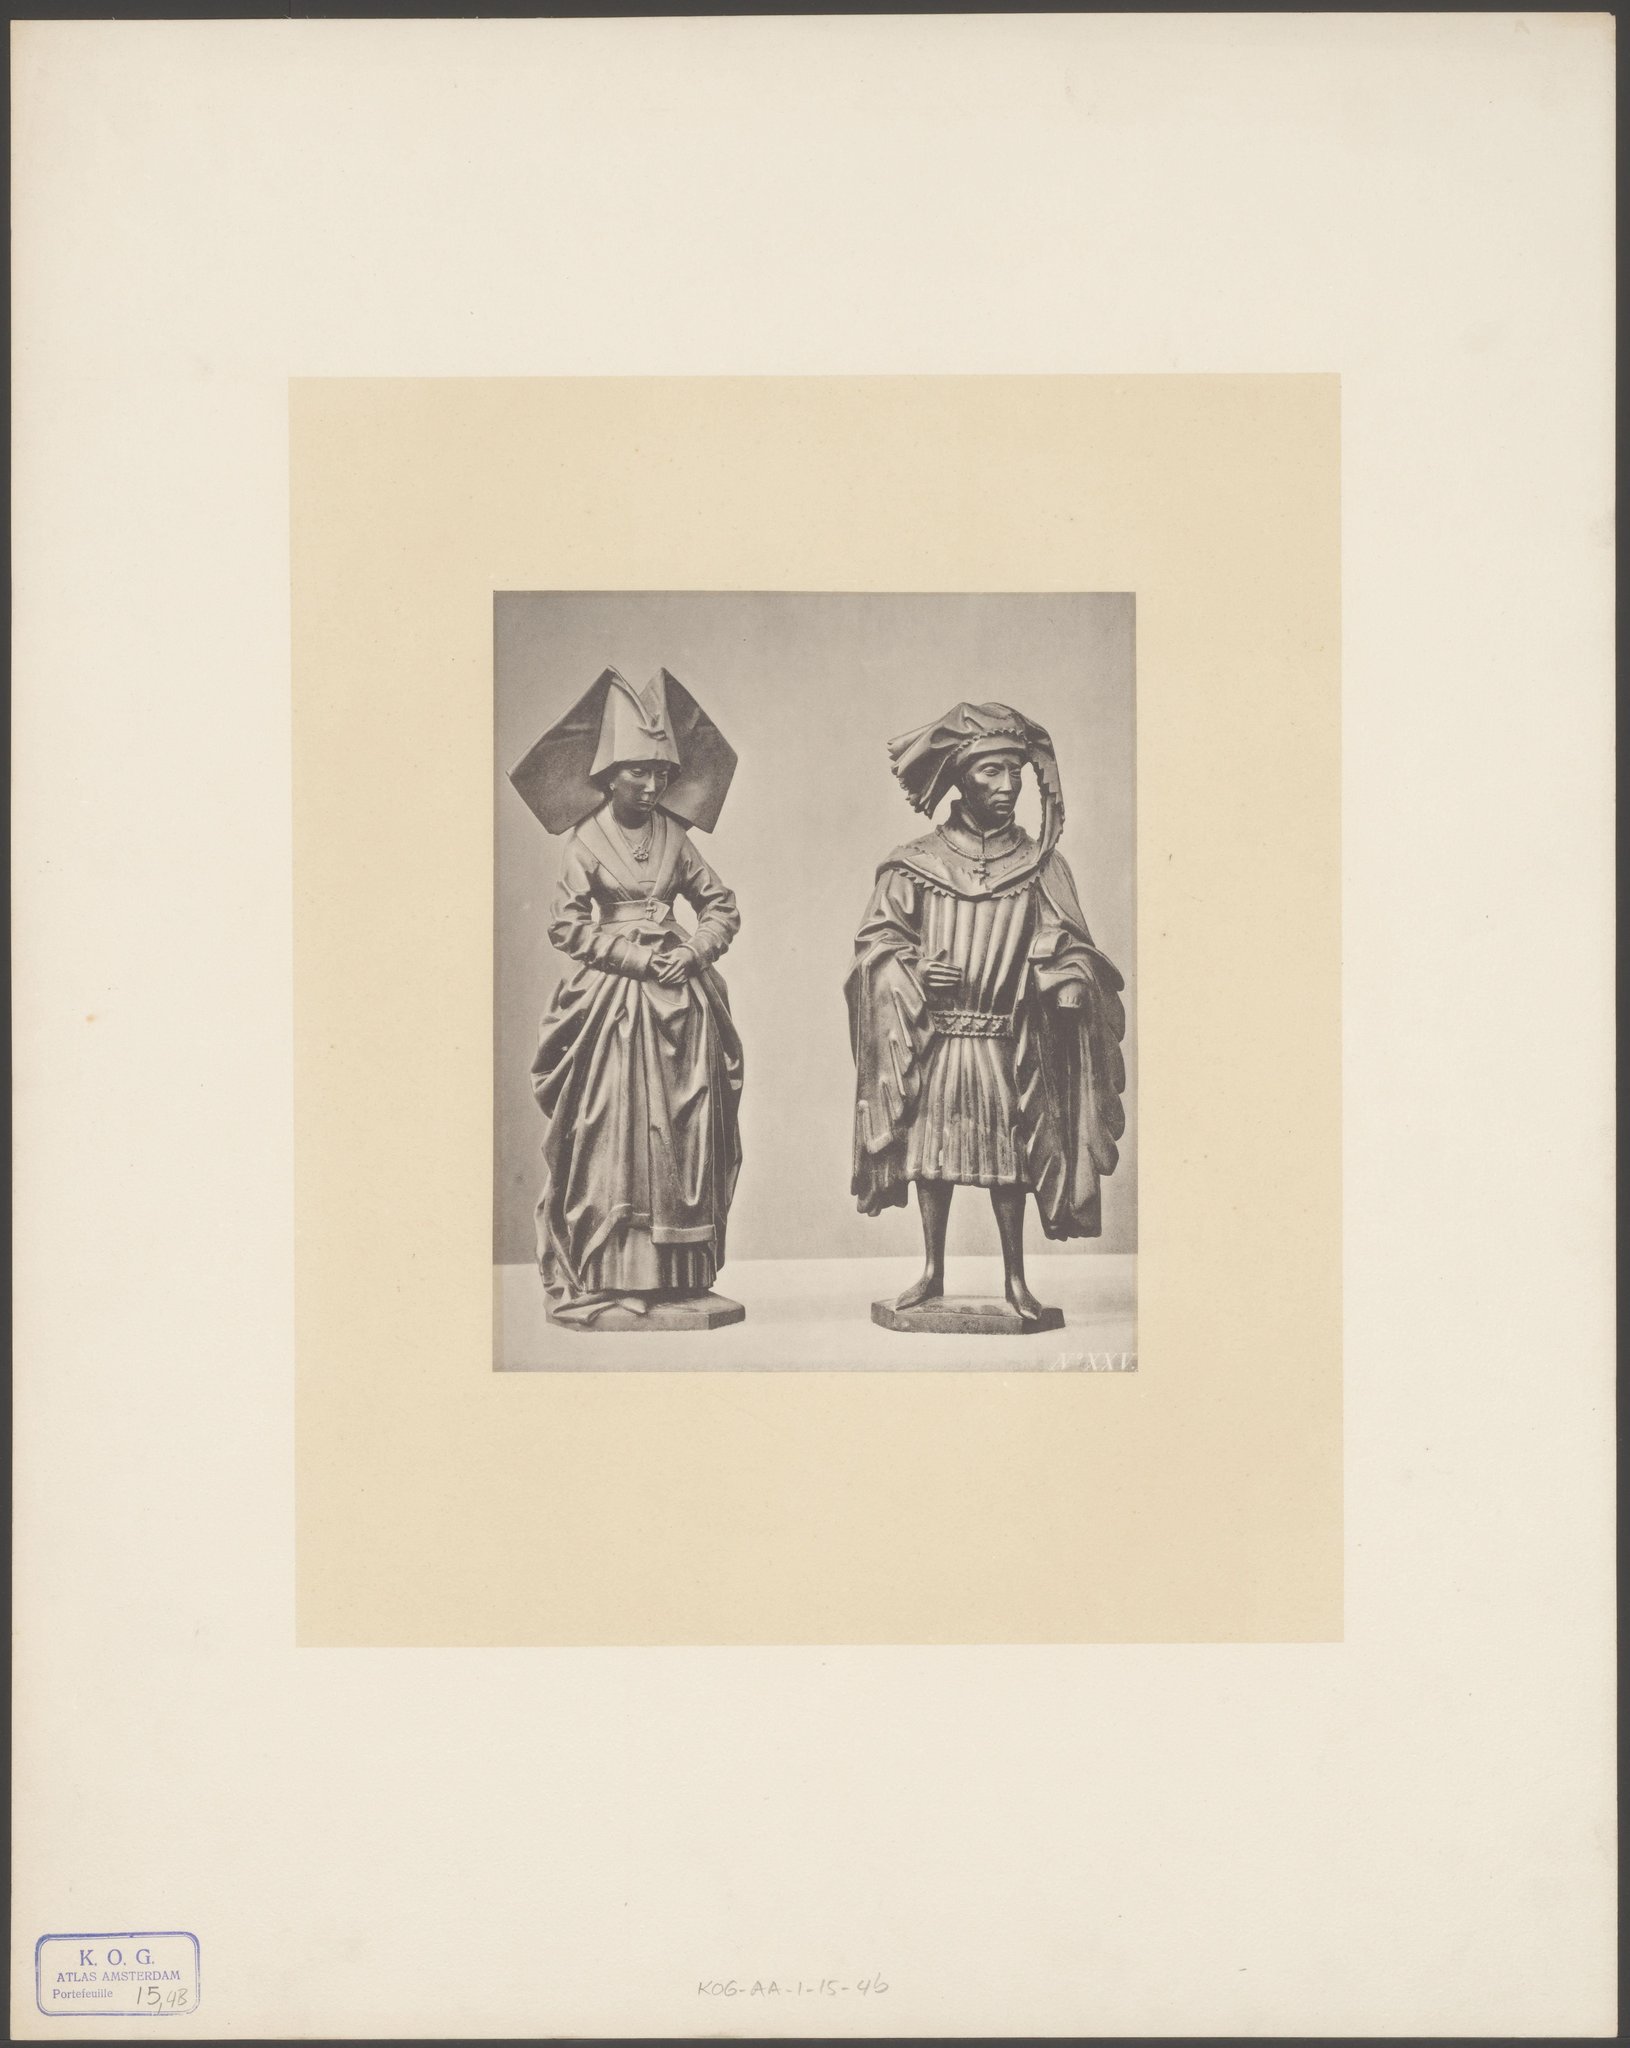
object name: photomechanical print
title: Twee sculpturen, mogelijk die op de vierschaar van het oude stadhuis van Amsterdam hebben gestaan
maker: Anonymous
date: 1875-1930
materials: paper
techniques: photograph, lithograph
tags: sculpture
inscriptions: collector's mark: ‘15,4B’ Lugt 1641b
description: Onderwerpsrubriek binnen de Atlas Amsterdam: Oude Stadhuis, Oude Stadhuis op den Dam: d. afbeelding der beeldjes gestaan hebbende op de vierschaar. Genummerd rechtsonder: No XXV.